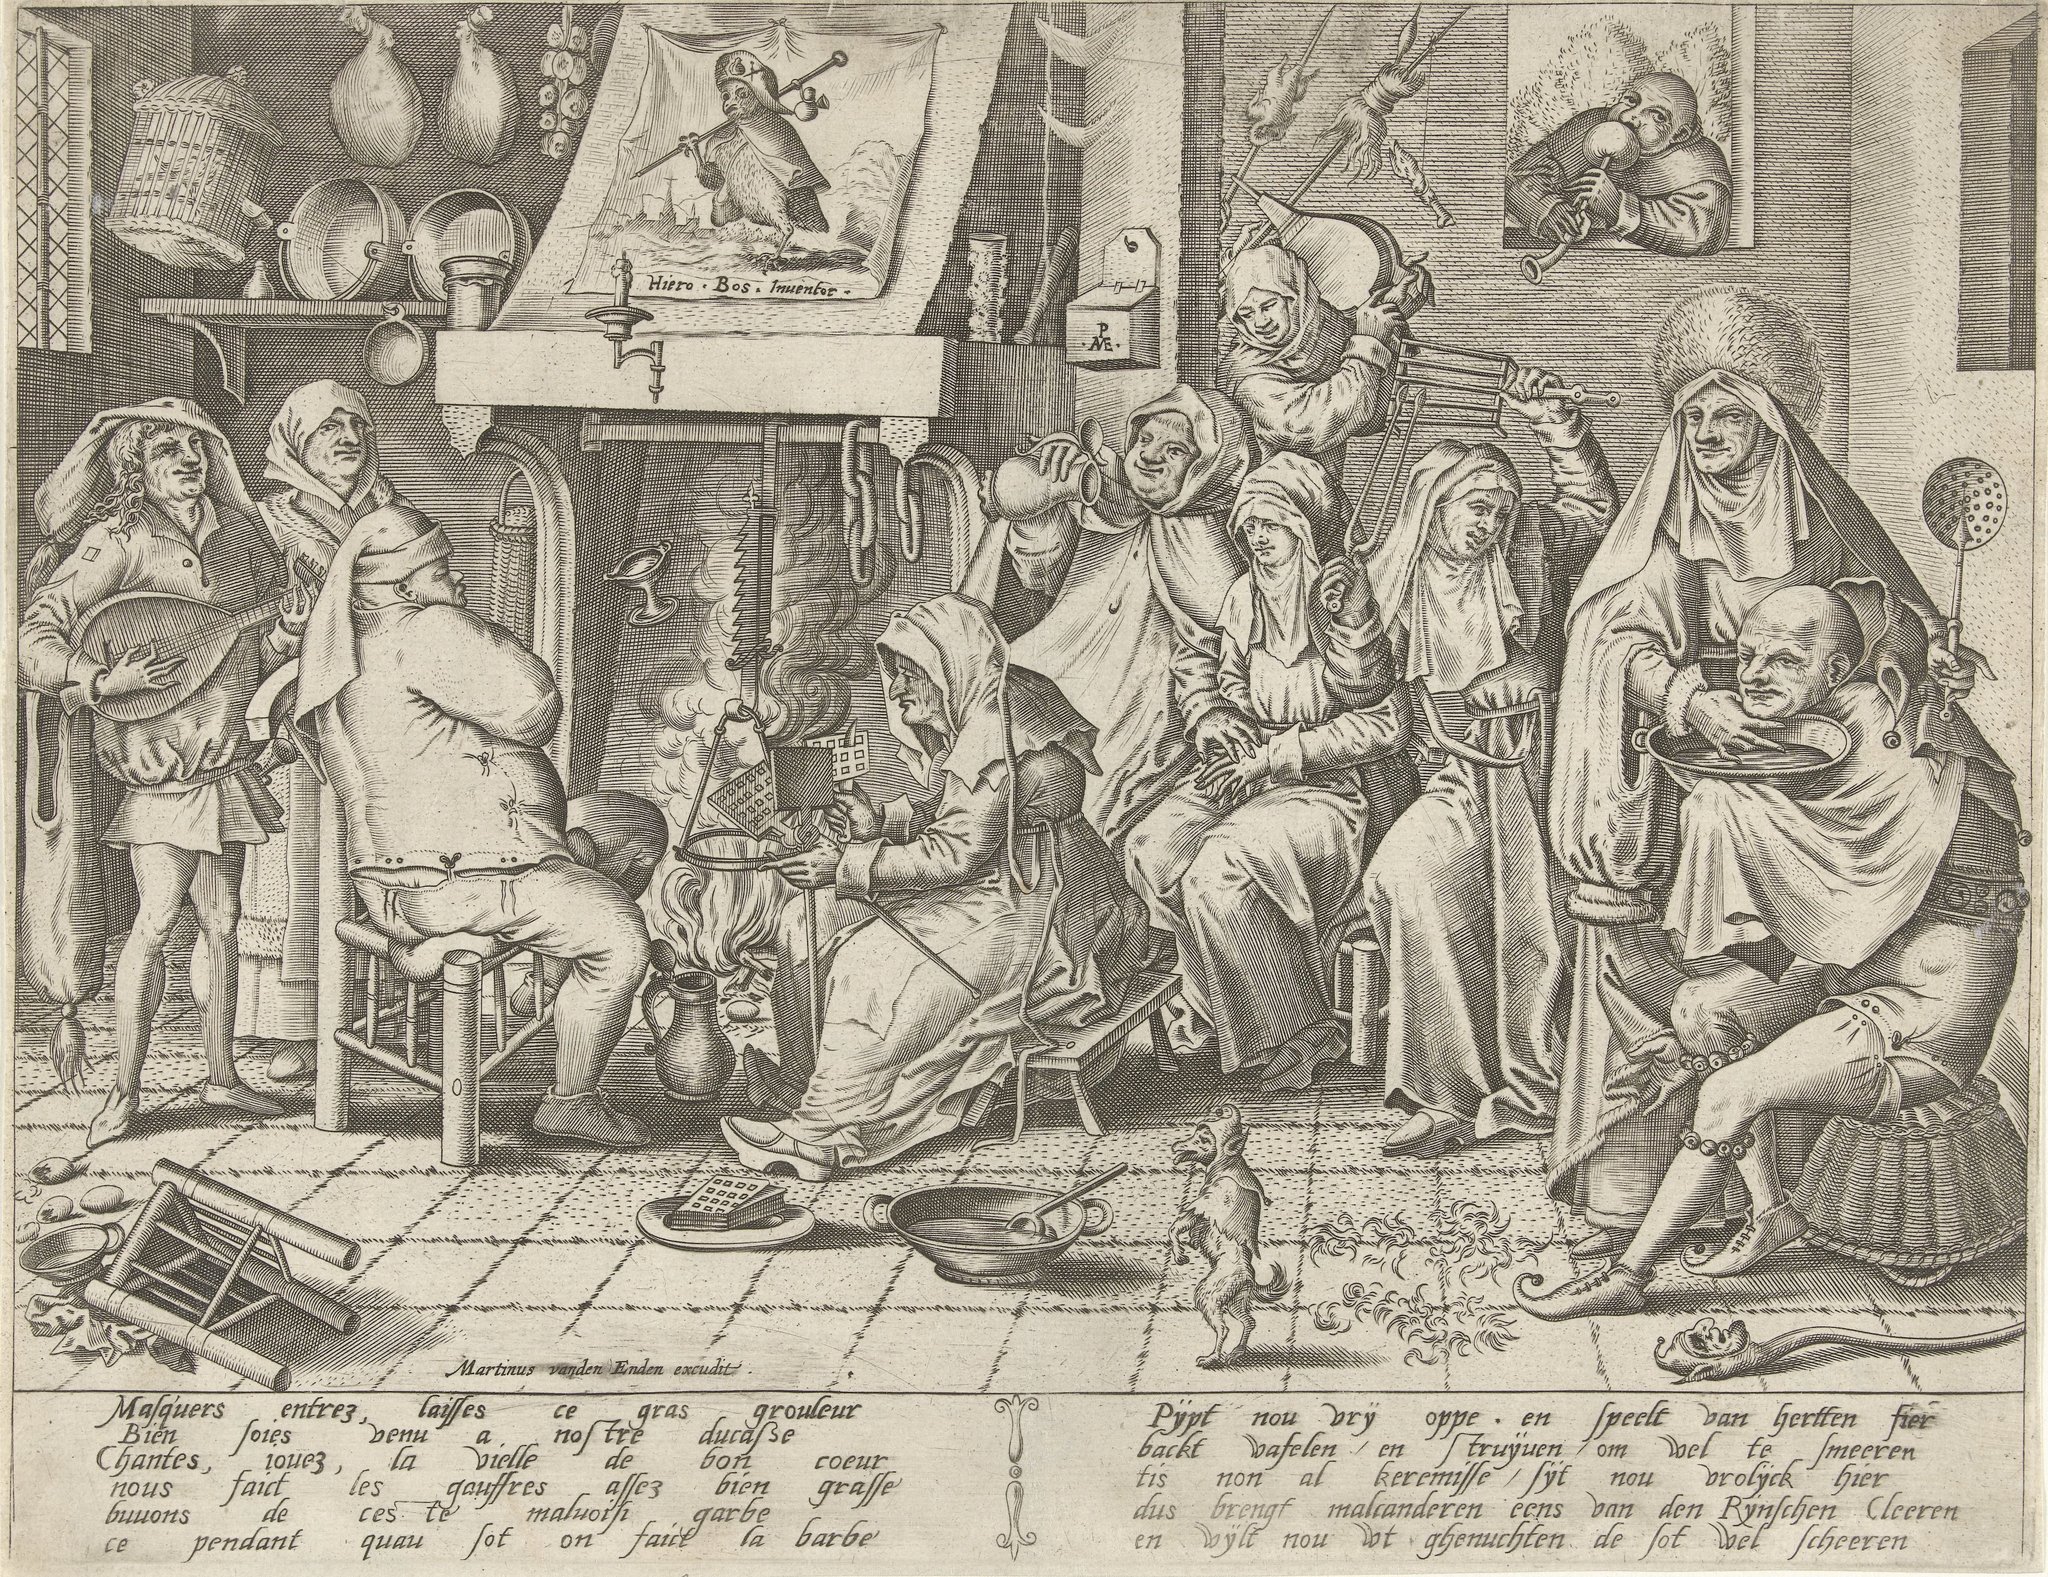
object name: print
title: Vastenavond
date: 1567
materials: paper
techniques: engraving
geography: antwerp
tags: fool, simpleton, numskull, monks and nuns, kitchen-interior, shaving, being shaved, (aspects of) christian religion or the church (as institution) ridiculed, criticized, or caricaturized, improvised musical instruments (kitchen-utensils, etc.), waffles, waffle-iron, shrove tuesday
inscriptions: collector's mark: Lugt 2228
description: In een interieur van een keuken bevindt zich een vrolijk gezelschap met een oude vrouw die bij de haard wafels bakt (vastenavond). Links een man met een luit, rechts een drinkende monnik met een non. Rechtsvoor wordt een nar geschoren, op de voorgrond een dansend hondje in een narrenkaproen. Boven de haard een prent met een uil als bedevaartganger. Met onderschrift van twee kolommen met links zes regels in het Frans en rechts vijf regels in het Nederlands.